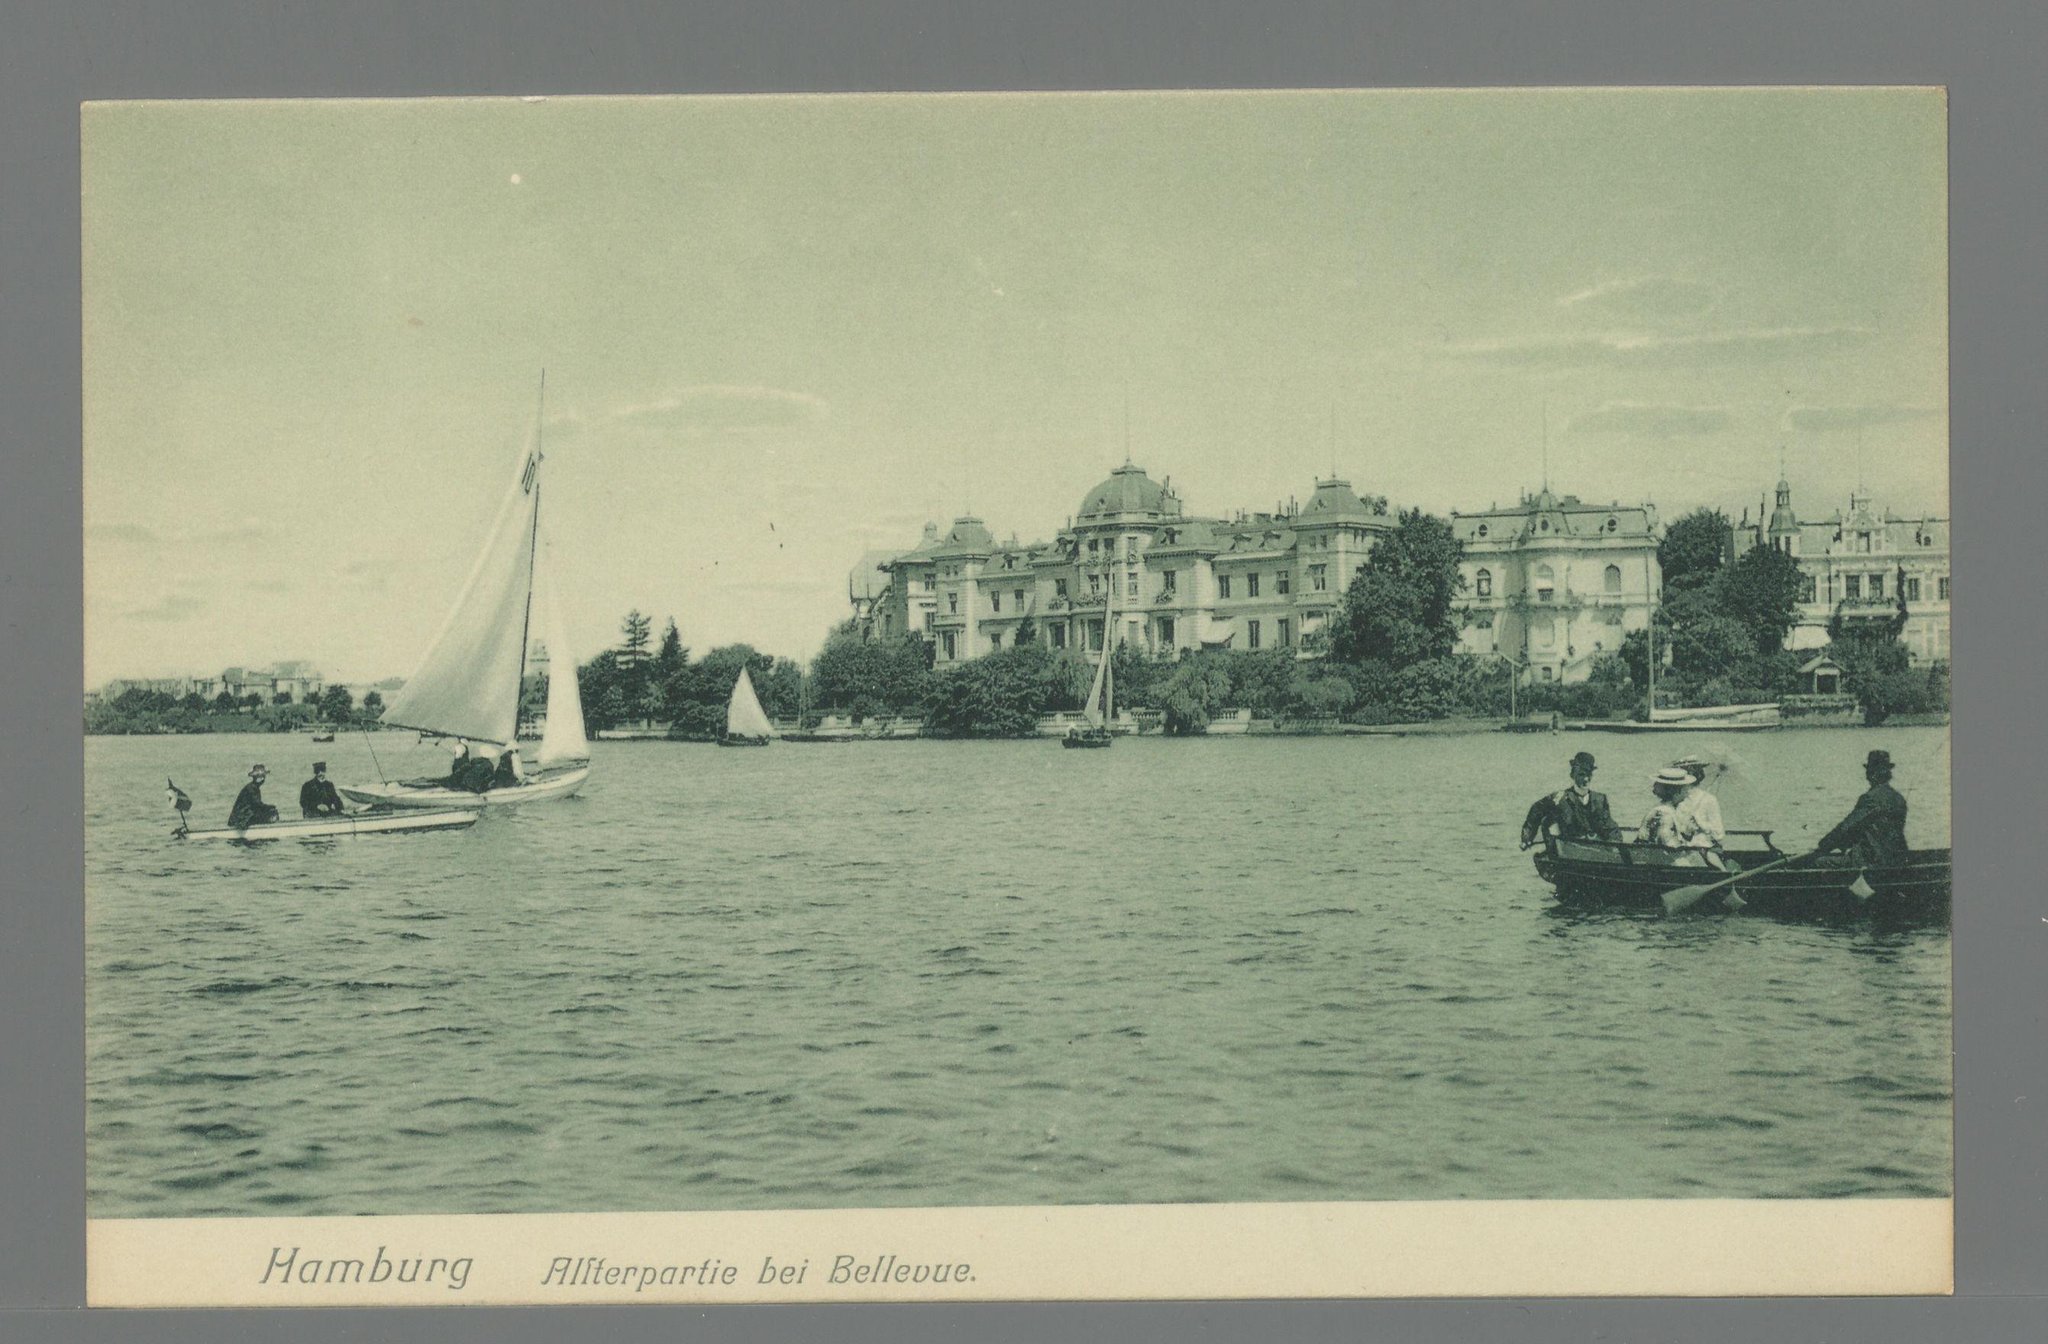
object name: photomechanical print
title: Luxusdruck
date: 1905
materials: cardboard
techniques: photograph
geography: hamburg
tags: ships (in general), canals, waters (in city)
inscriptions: date